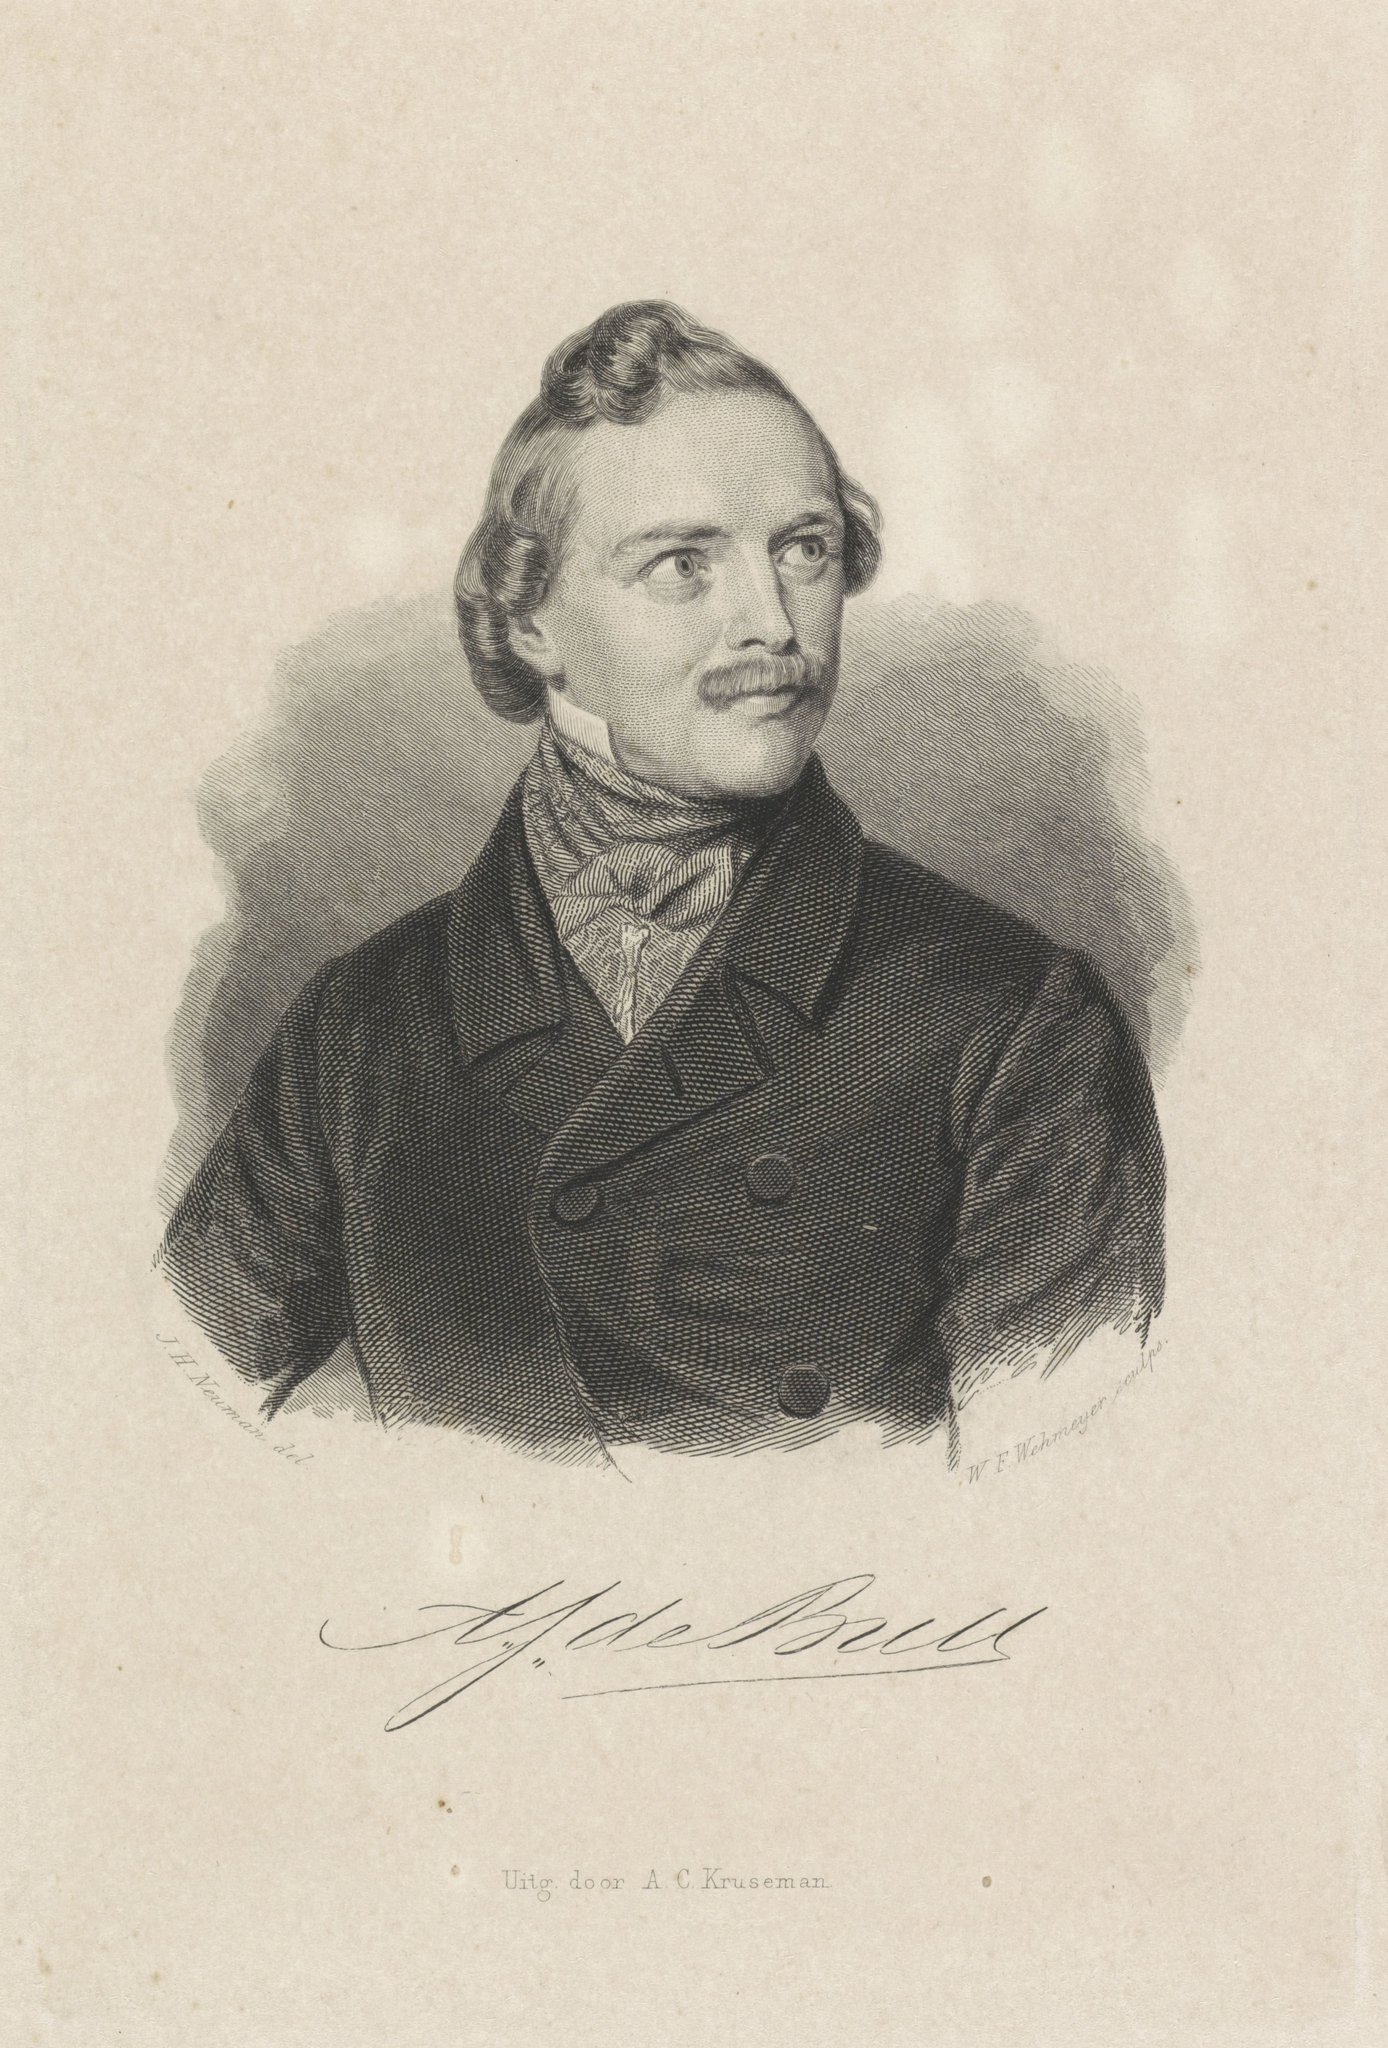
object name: print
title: Portret van Abraham Johannes de Bull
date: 1842-1873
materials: paper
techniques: engraving, etching, roulette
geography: amsterdam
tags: adult man, historical persons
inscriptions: collector's mark: Lugt 2228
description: Portret van Abraham Johannes Bull, journalist en auteur. Onder de voorstelling de signatuur van de geportretteerde.